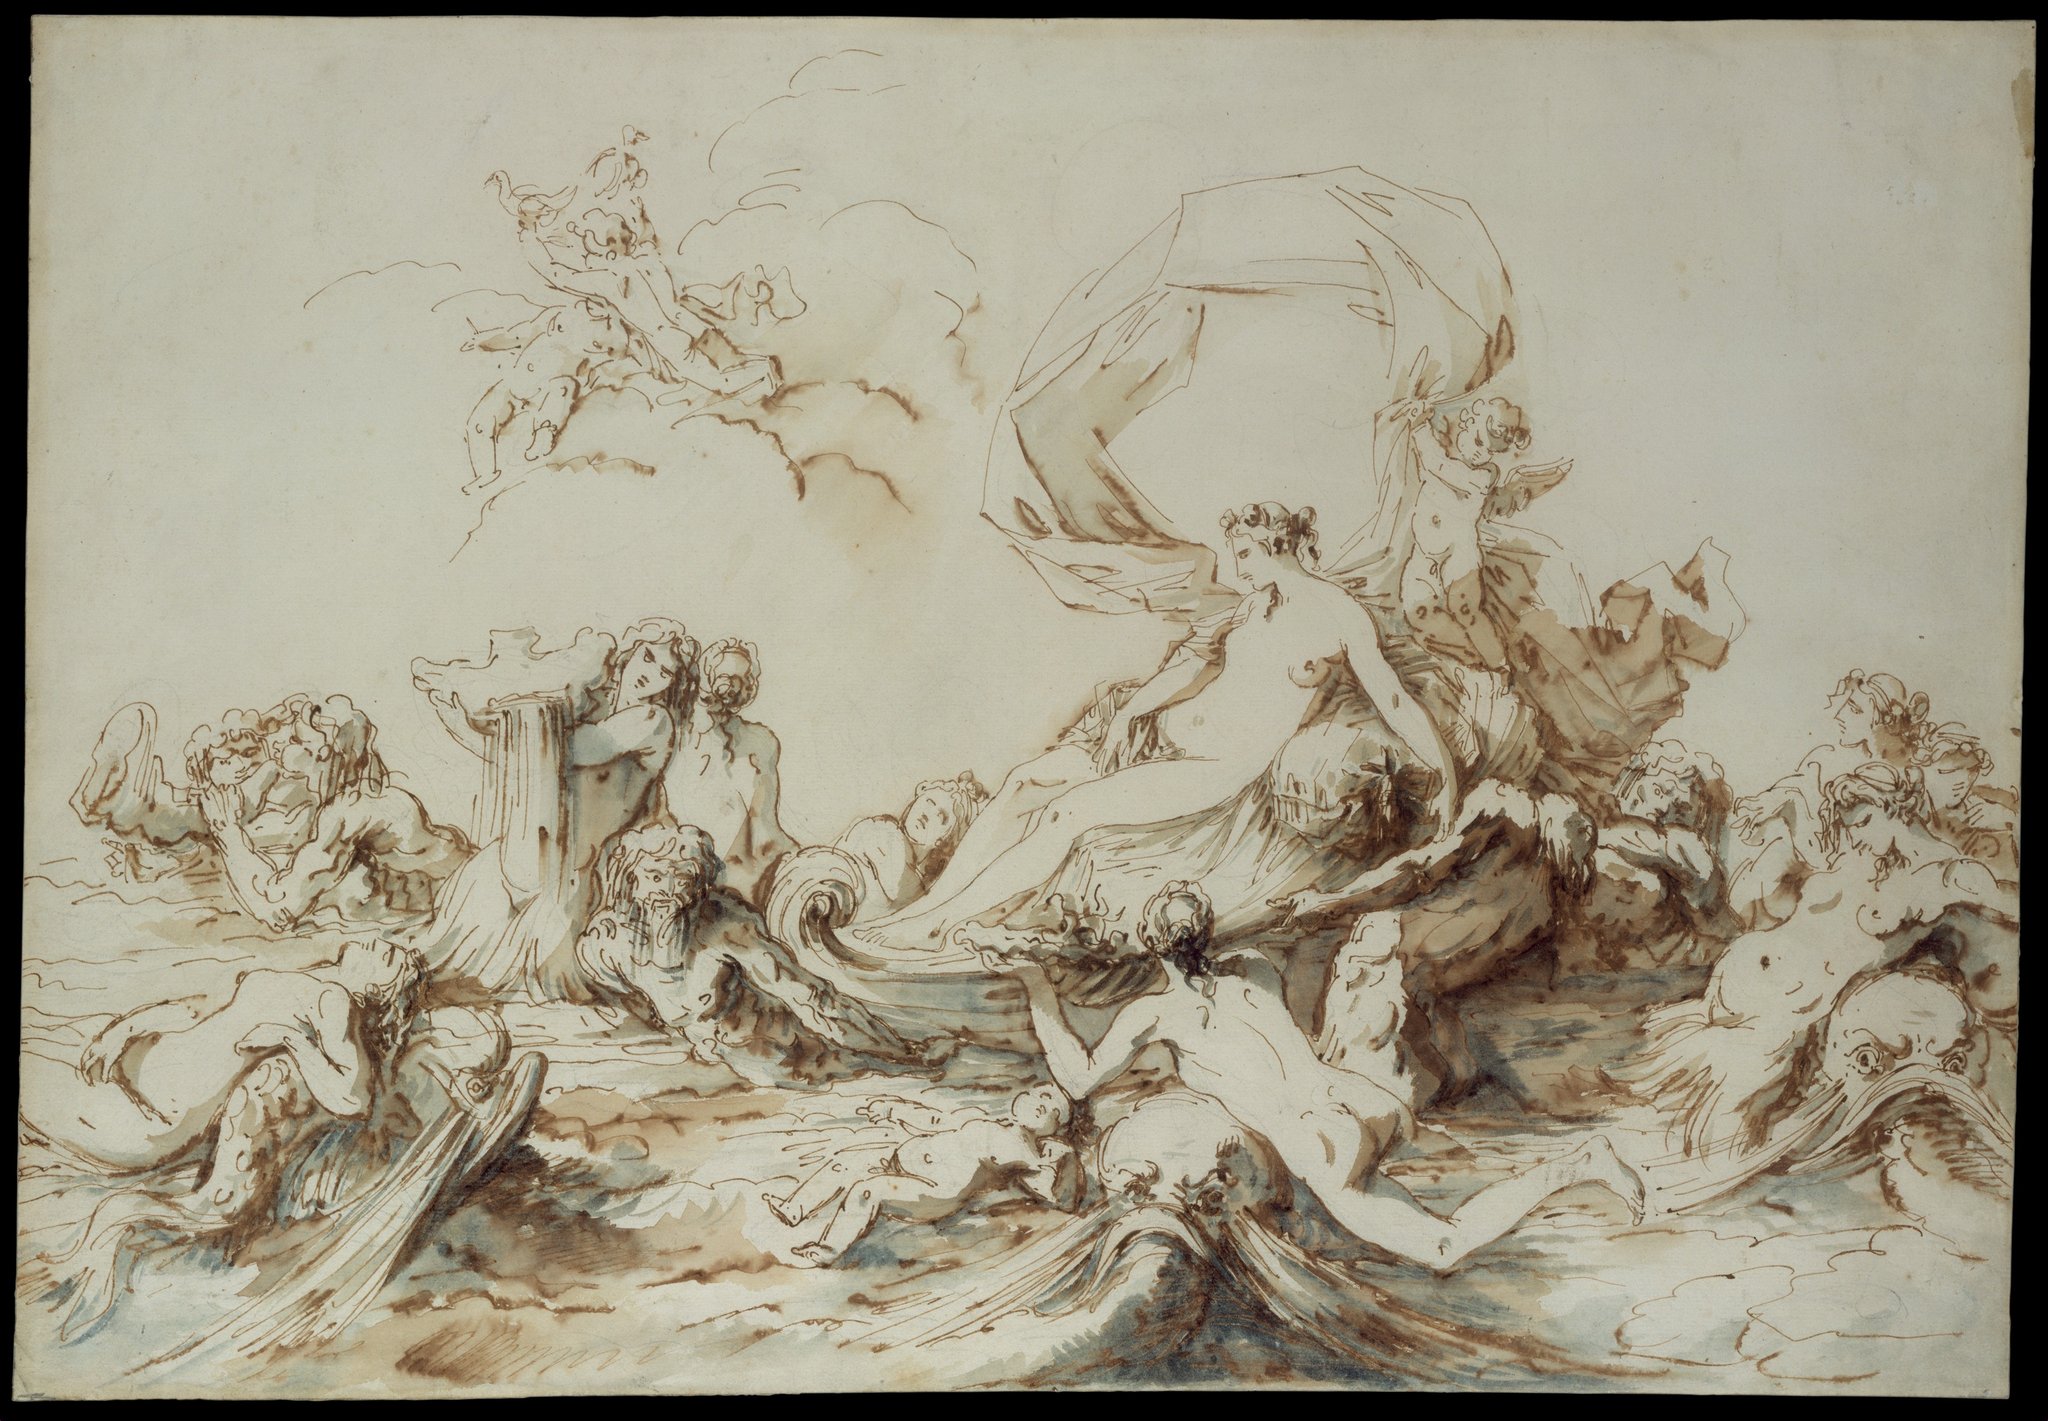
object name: drawing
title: The Triumph of Venus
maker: andré lebrun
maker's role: artist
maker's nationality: french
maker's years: 1737-1811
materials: chalk, ink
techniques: brush, pen, wash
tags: female nudes,venus